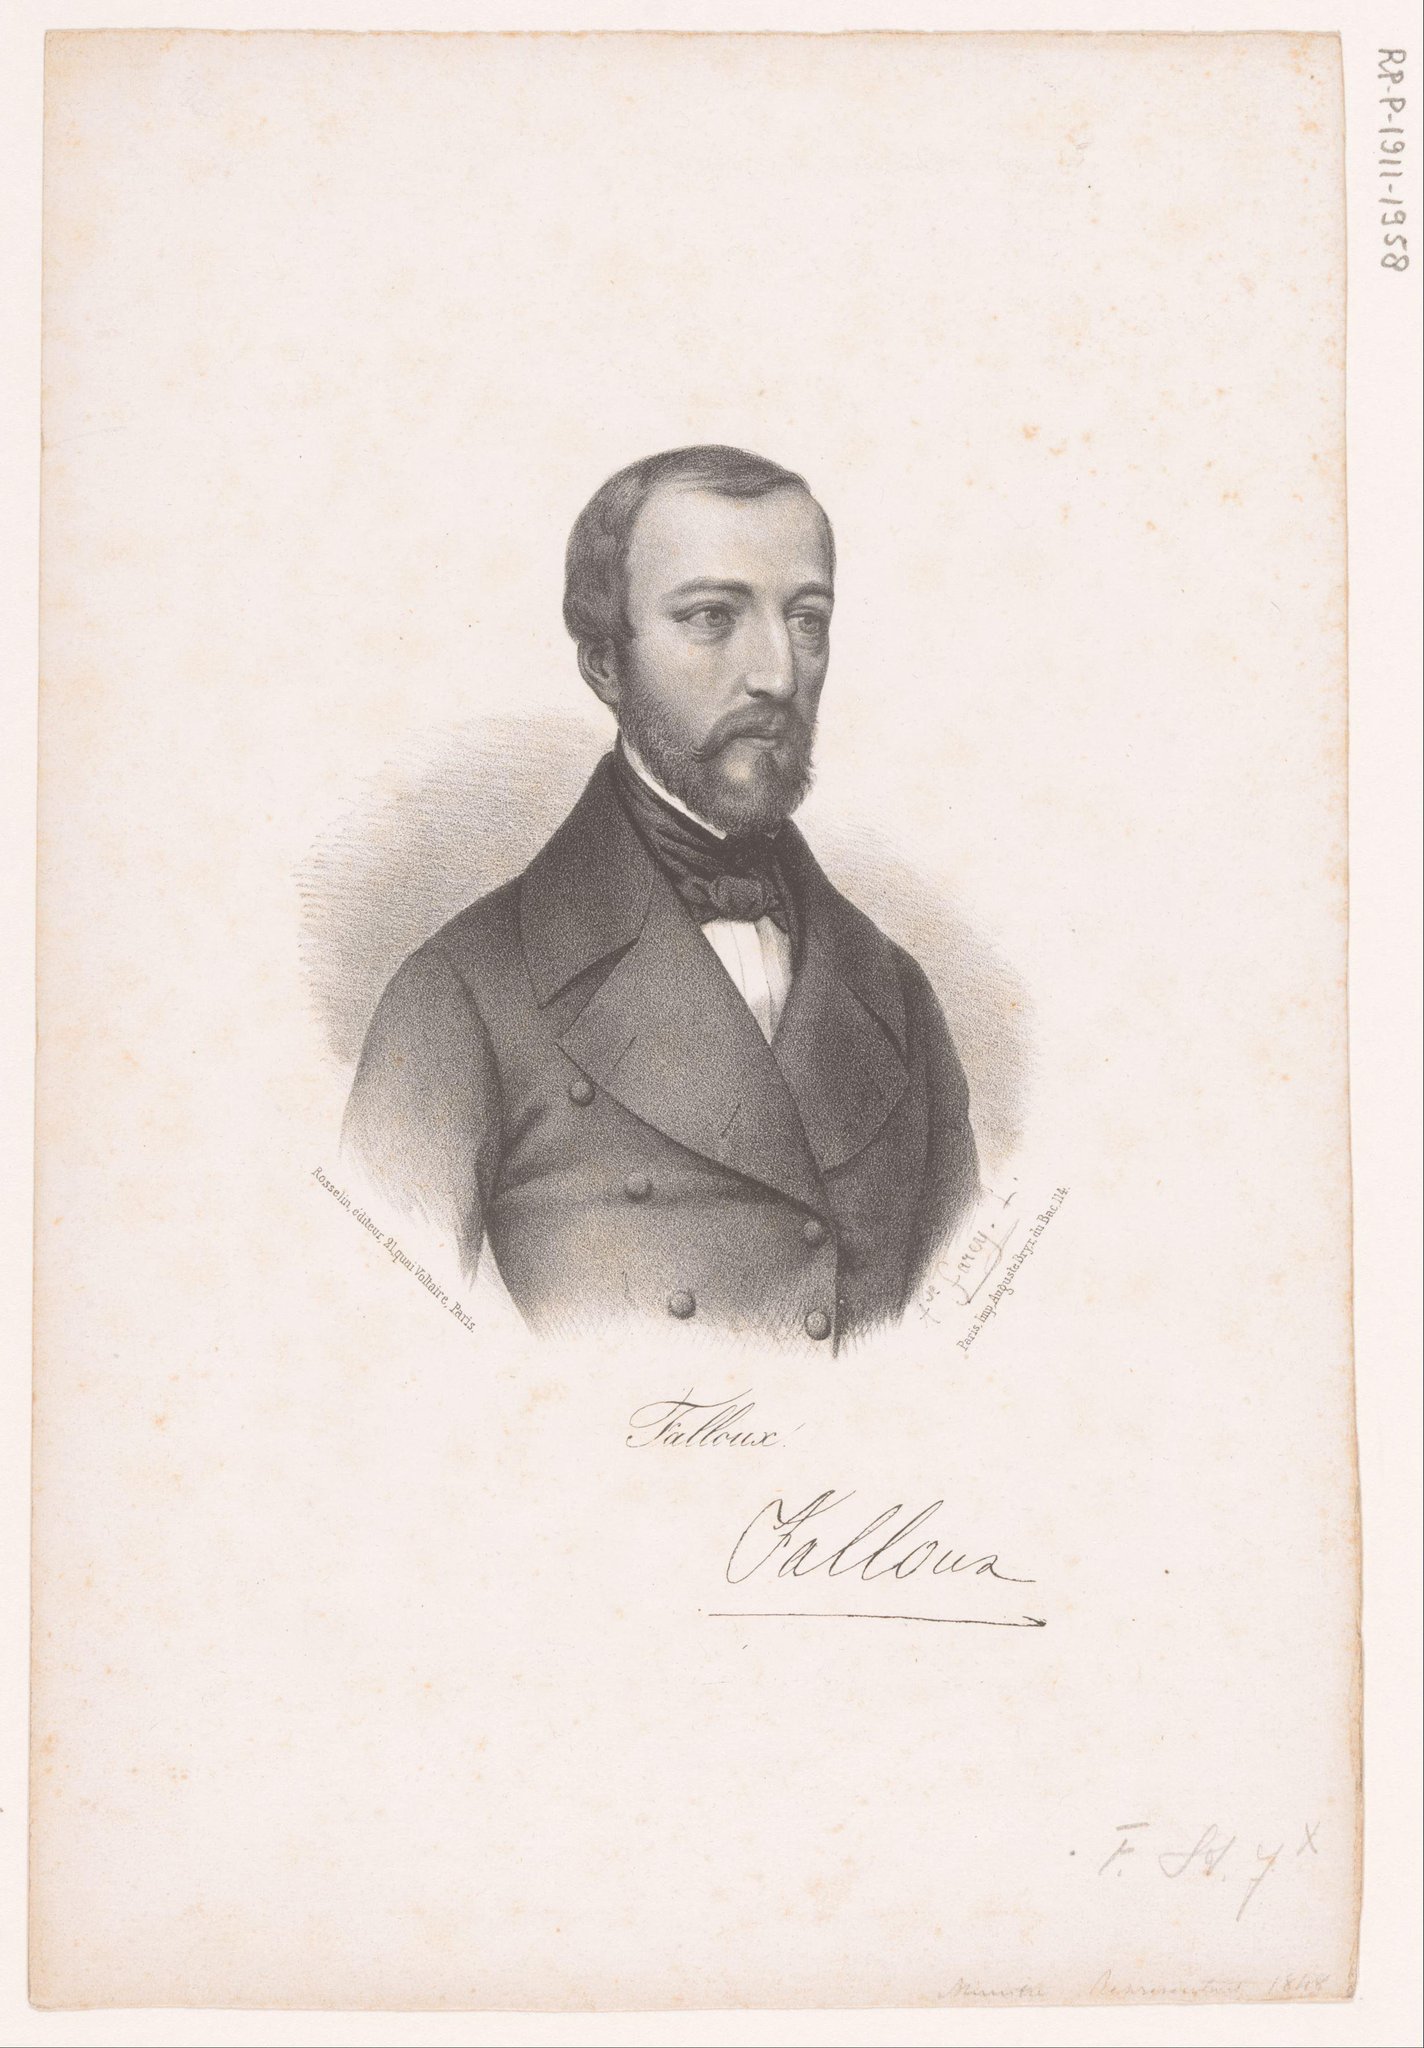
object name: print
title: Falloux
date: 1852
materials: paper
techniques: lithograph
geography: paris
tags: politician, alfred de falloux, historical persons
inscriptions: collector's mark: Lugt 2228a